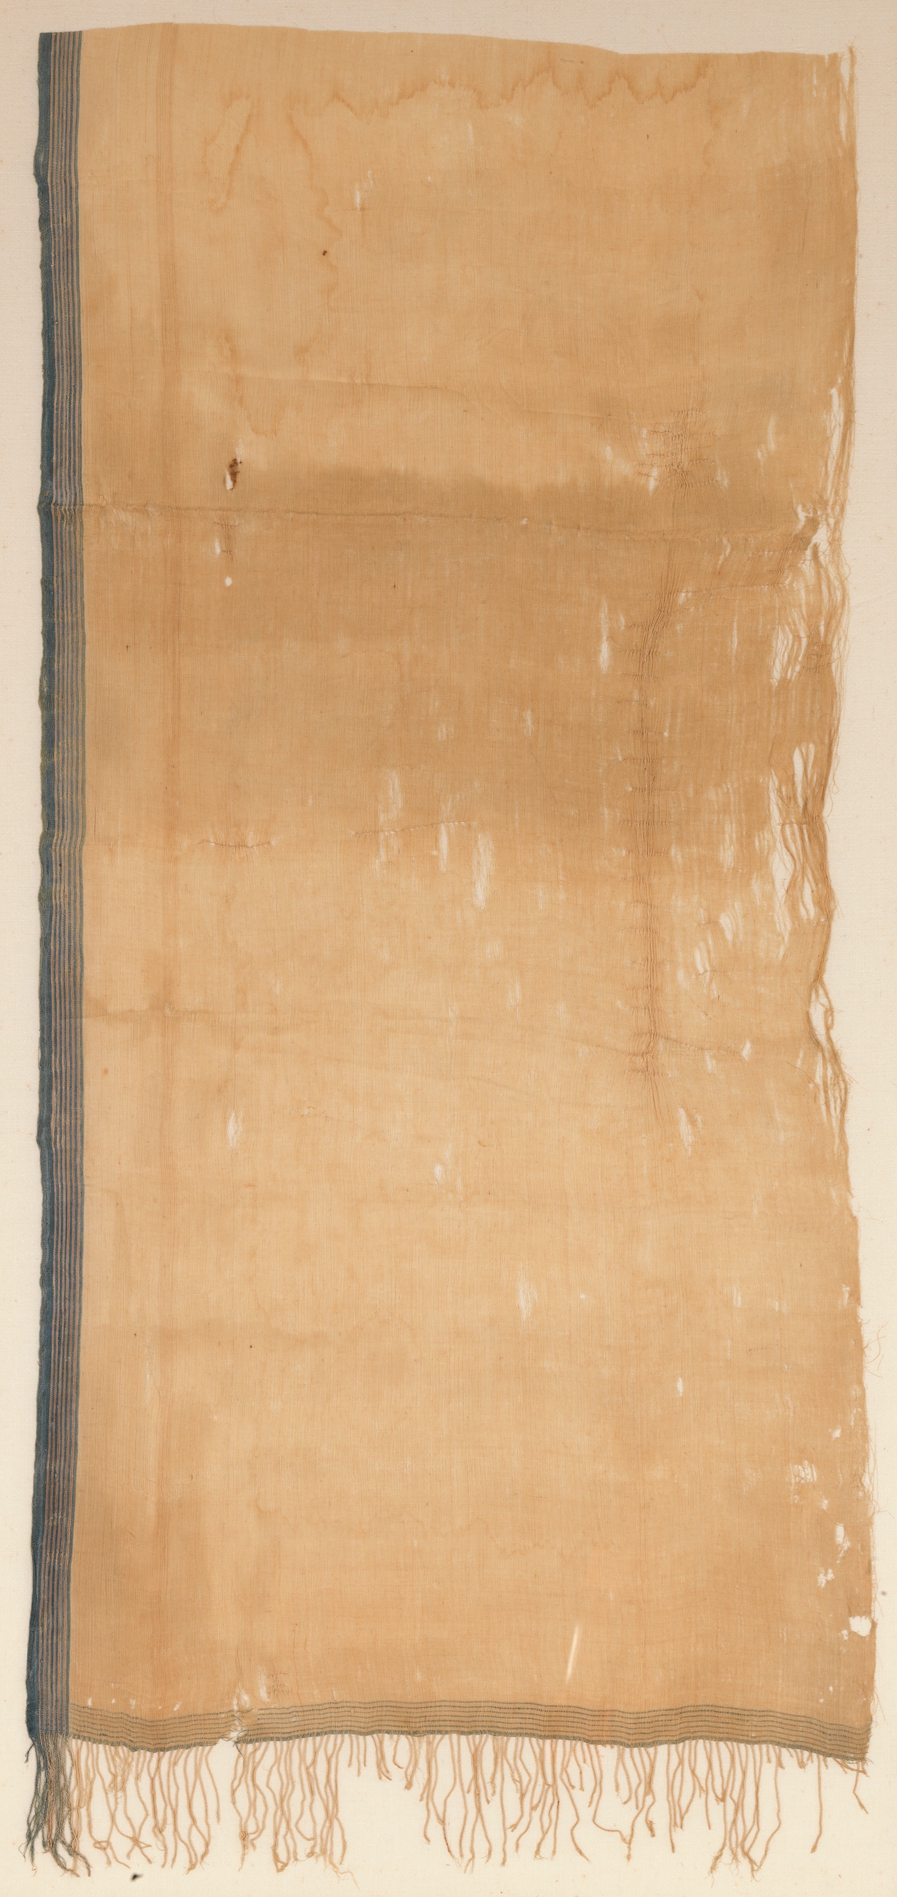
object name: cloth, linen, blue and red dye, fringed, djedptahefankh, mummy cloth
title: Mummy Cloth Fragment of Djedptahefankh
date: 1070-945 BCE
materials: linen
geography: upper egypt, thebes